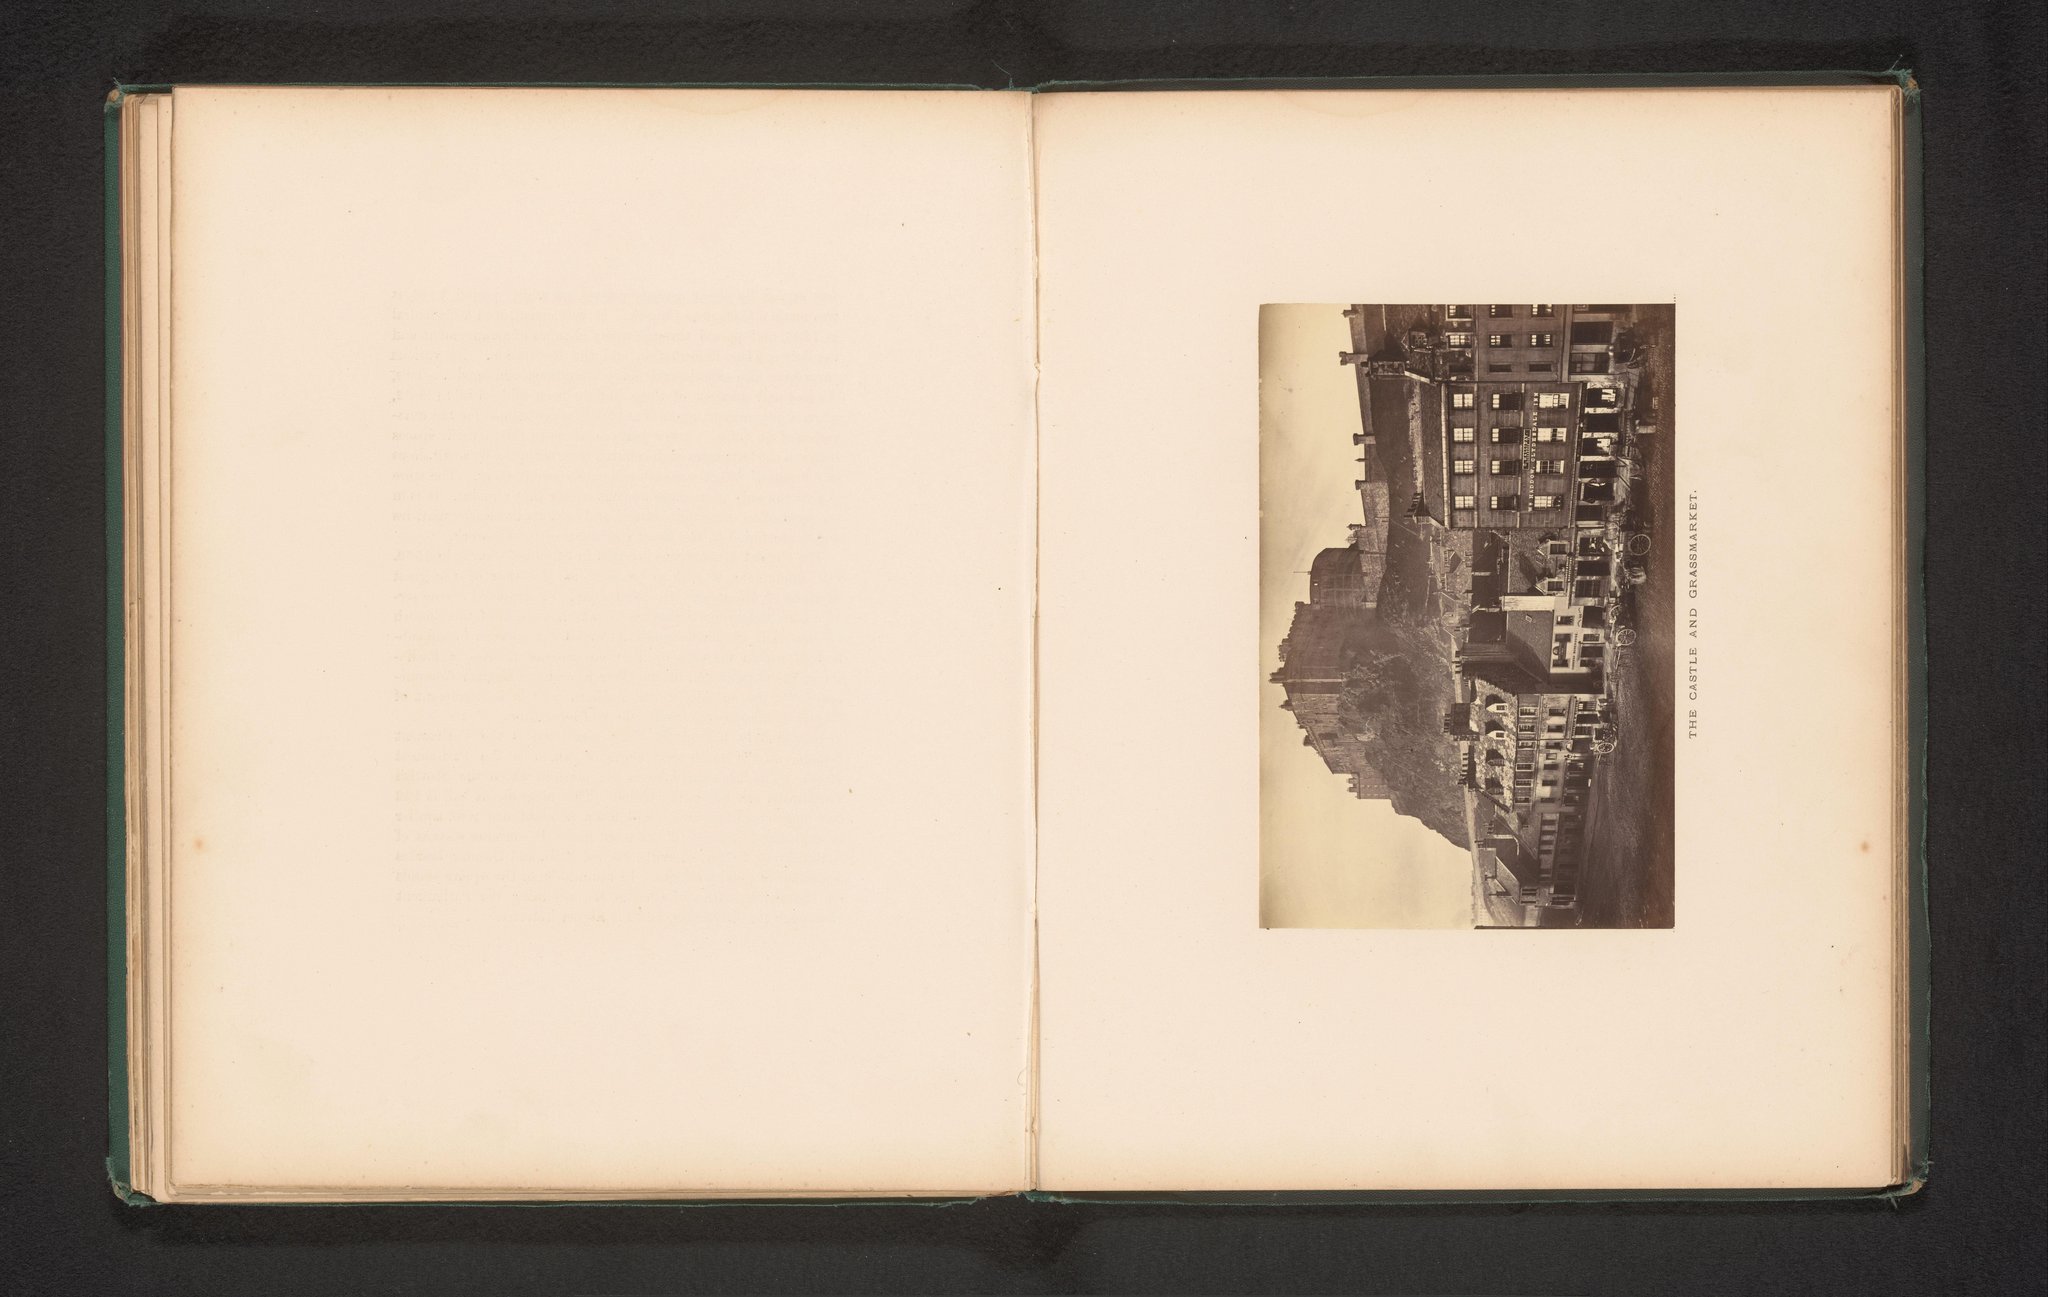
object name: photograph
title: The castle and grassmarket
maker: archibald burns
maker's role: fotograaf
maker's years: 1831-1880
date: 1862-1867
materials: photographic support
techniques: albumen print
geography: edinburgh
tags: hand-cart, city-view in general; 'veduta', castle, civic architecture; edifices; dwellings